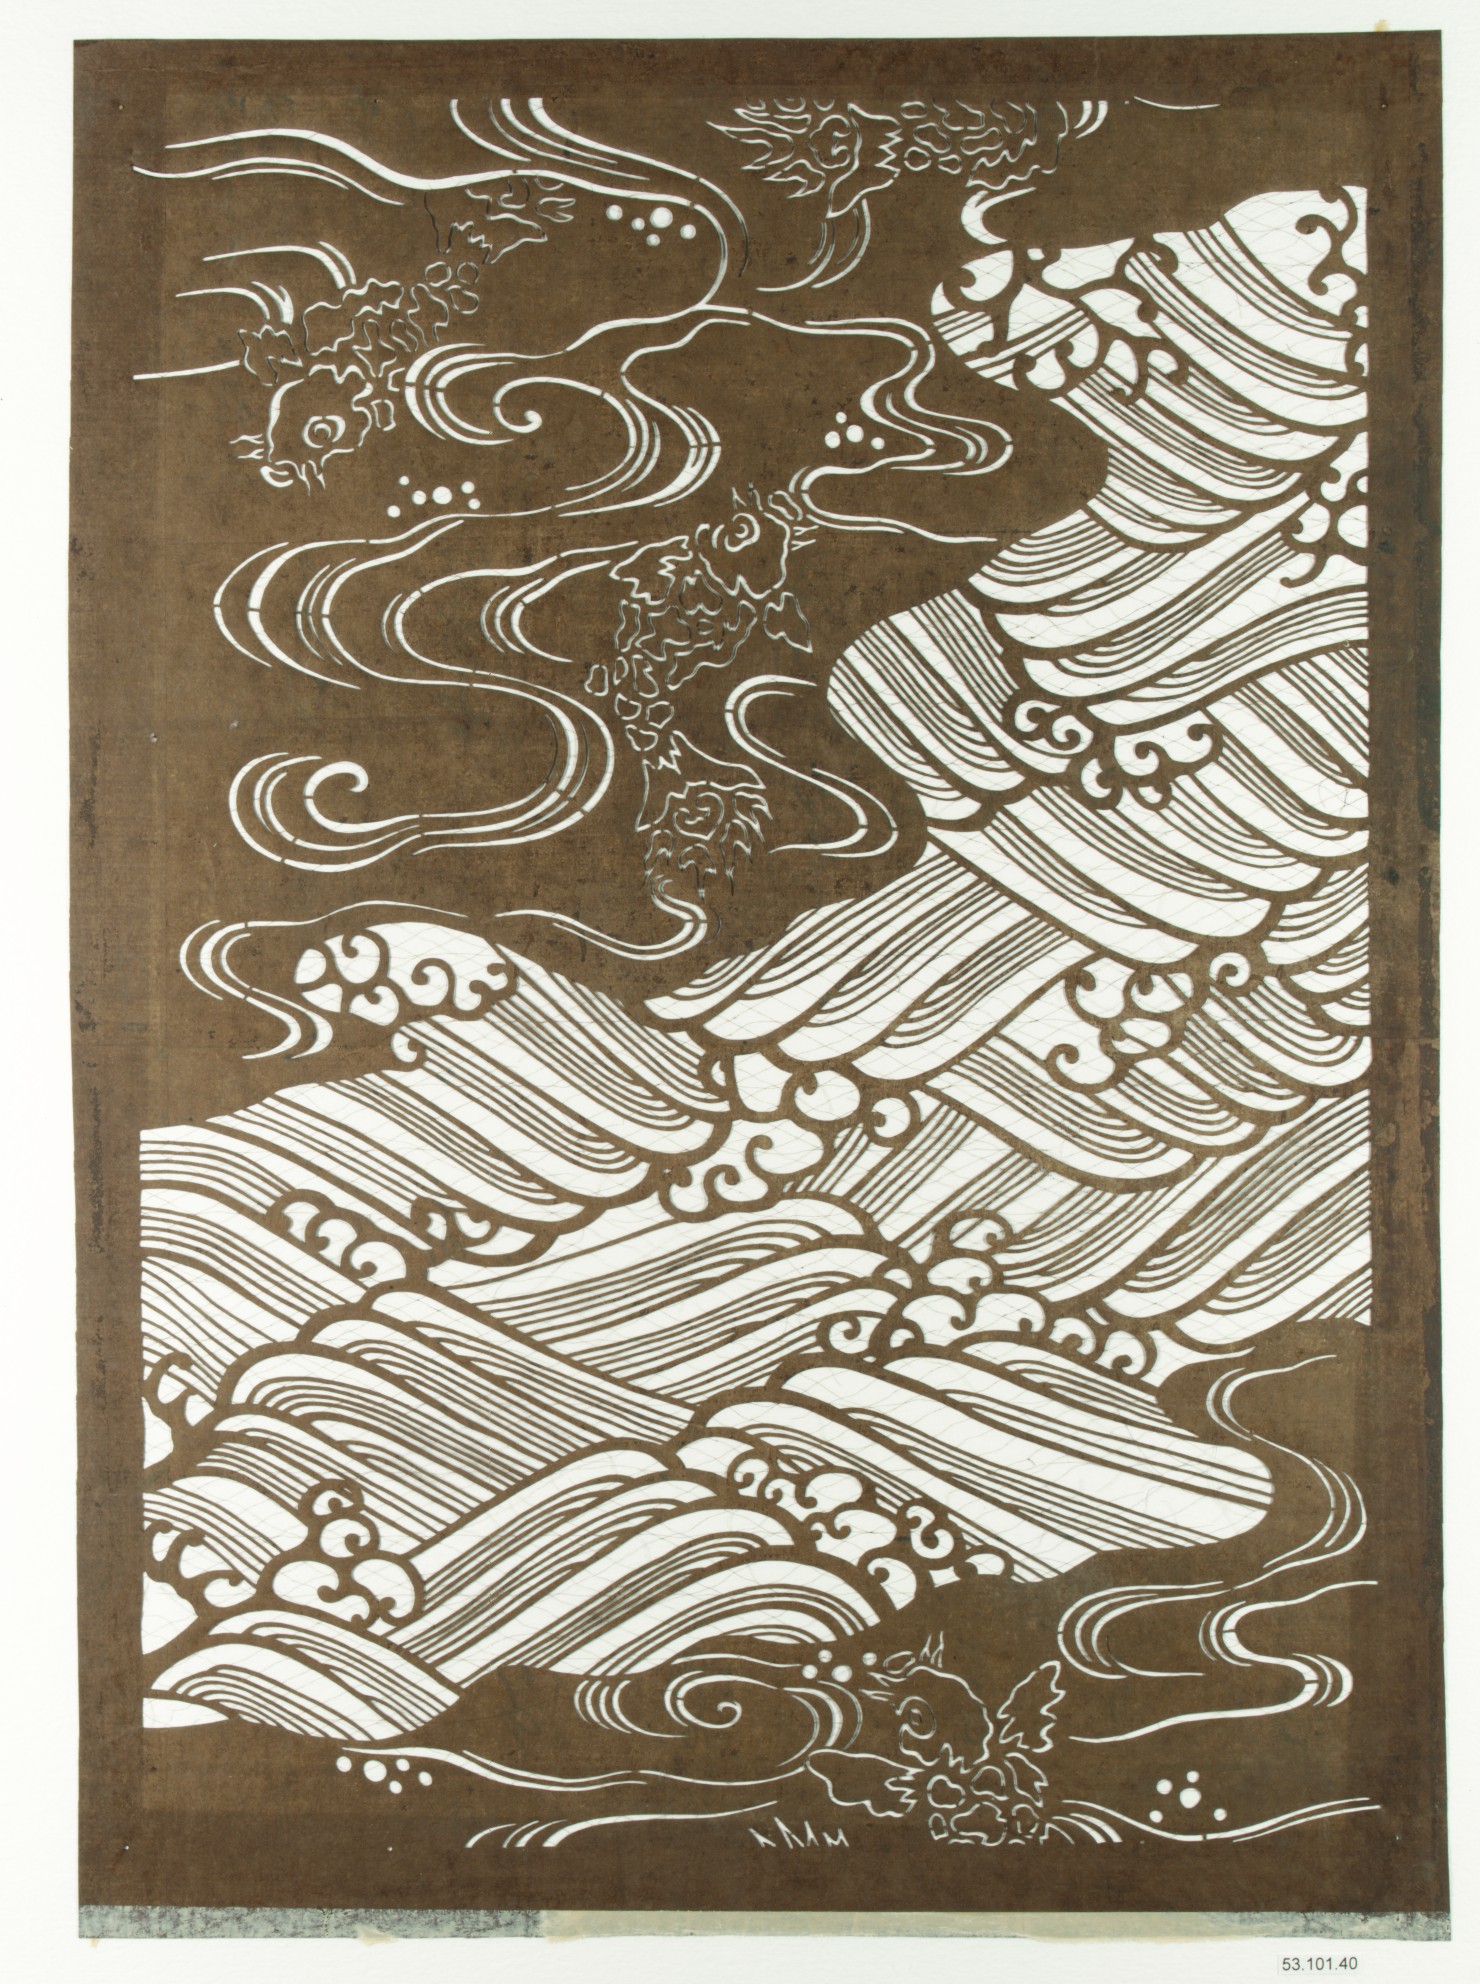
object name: stencil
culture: japanese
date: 1615-1868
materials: paper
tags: fish,waves